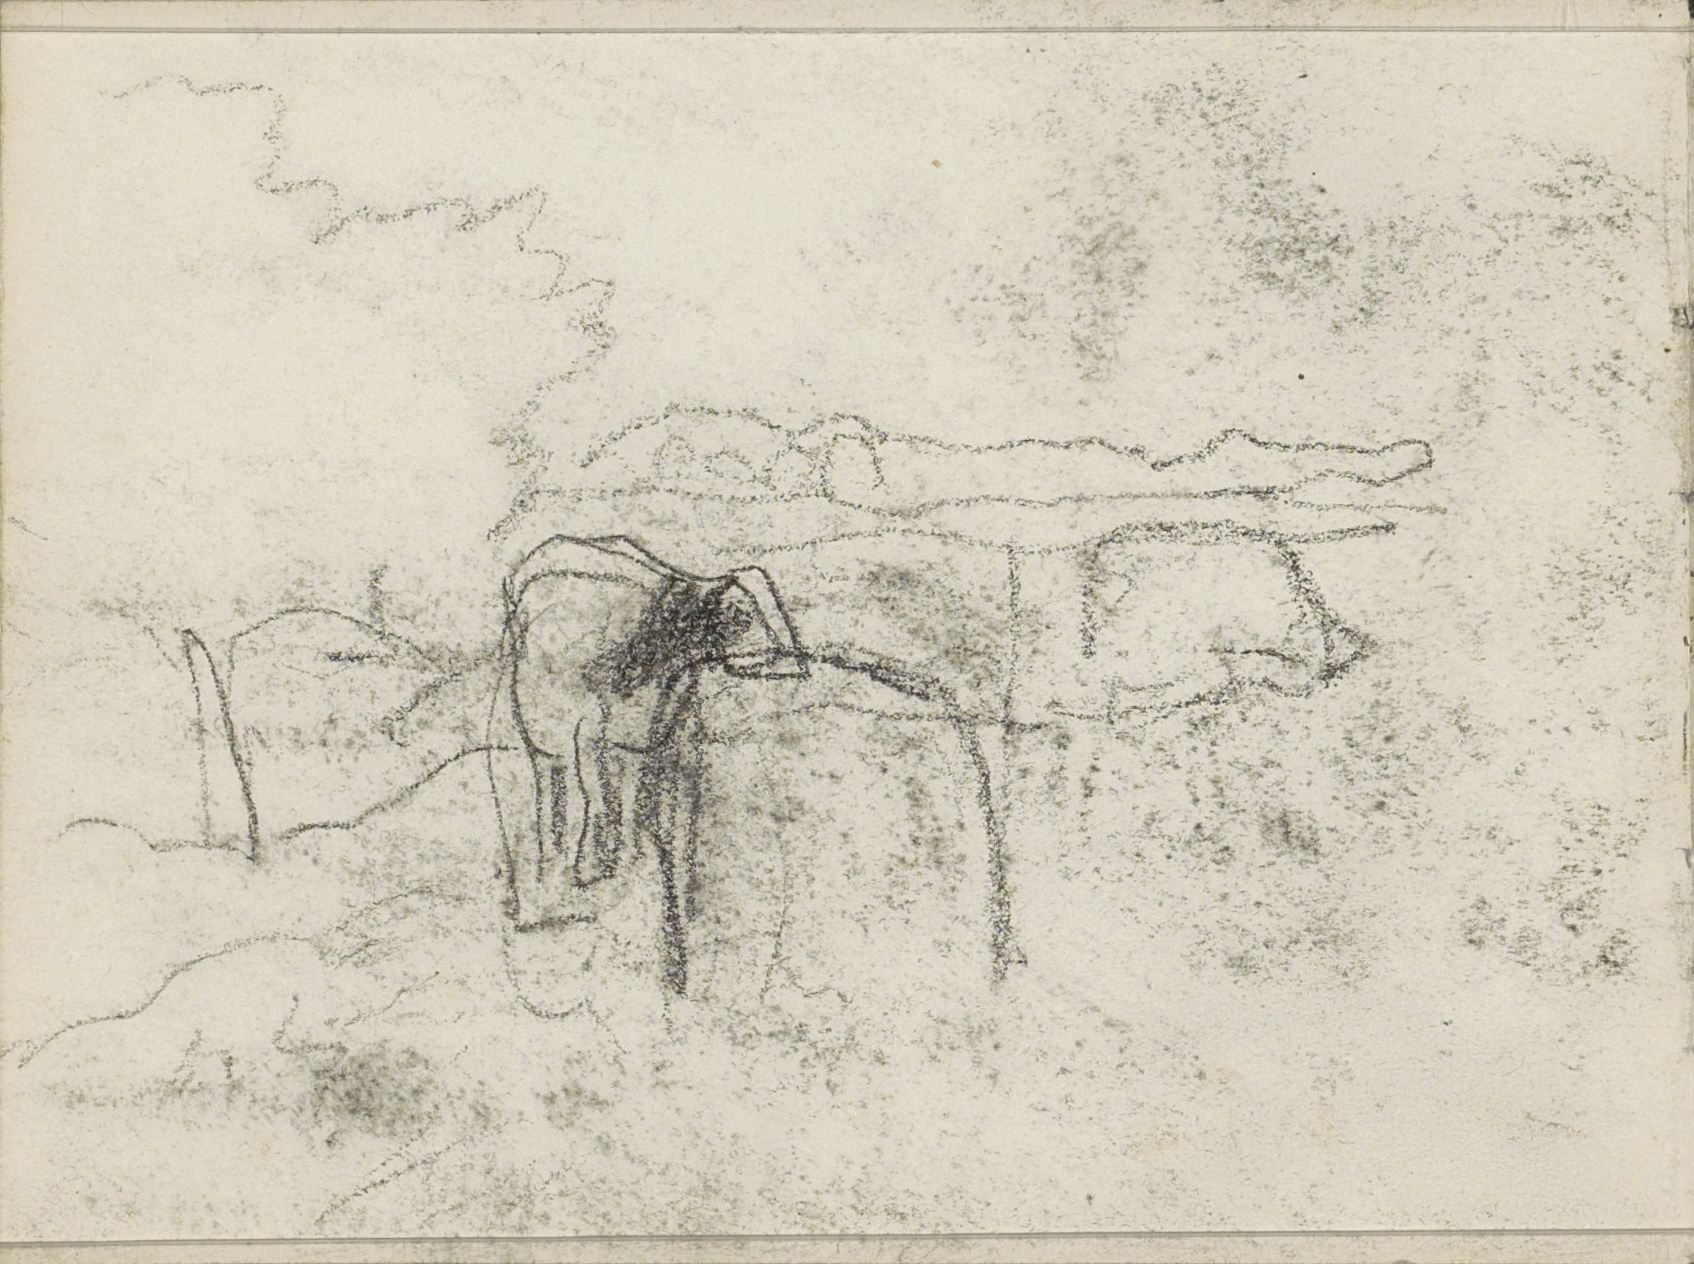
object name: sketchbook leaf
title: Koe in een landschap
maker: anton mauve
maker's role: draughtsman, painter, print maker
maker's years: 1838-1888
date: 1881-1888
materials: chalk, paper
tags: cow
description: Blad 3 verso uit een schetsboek met 29 bladen.